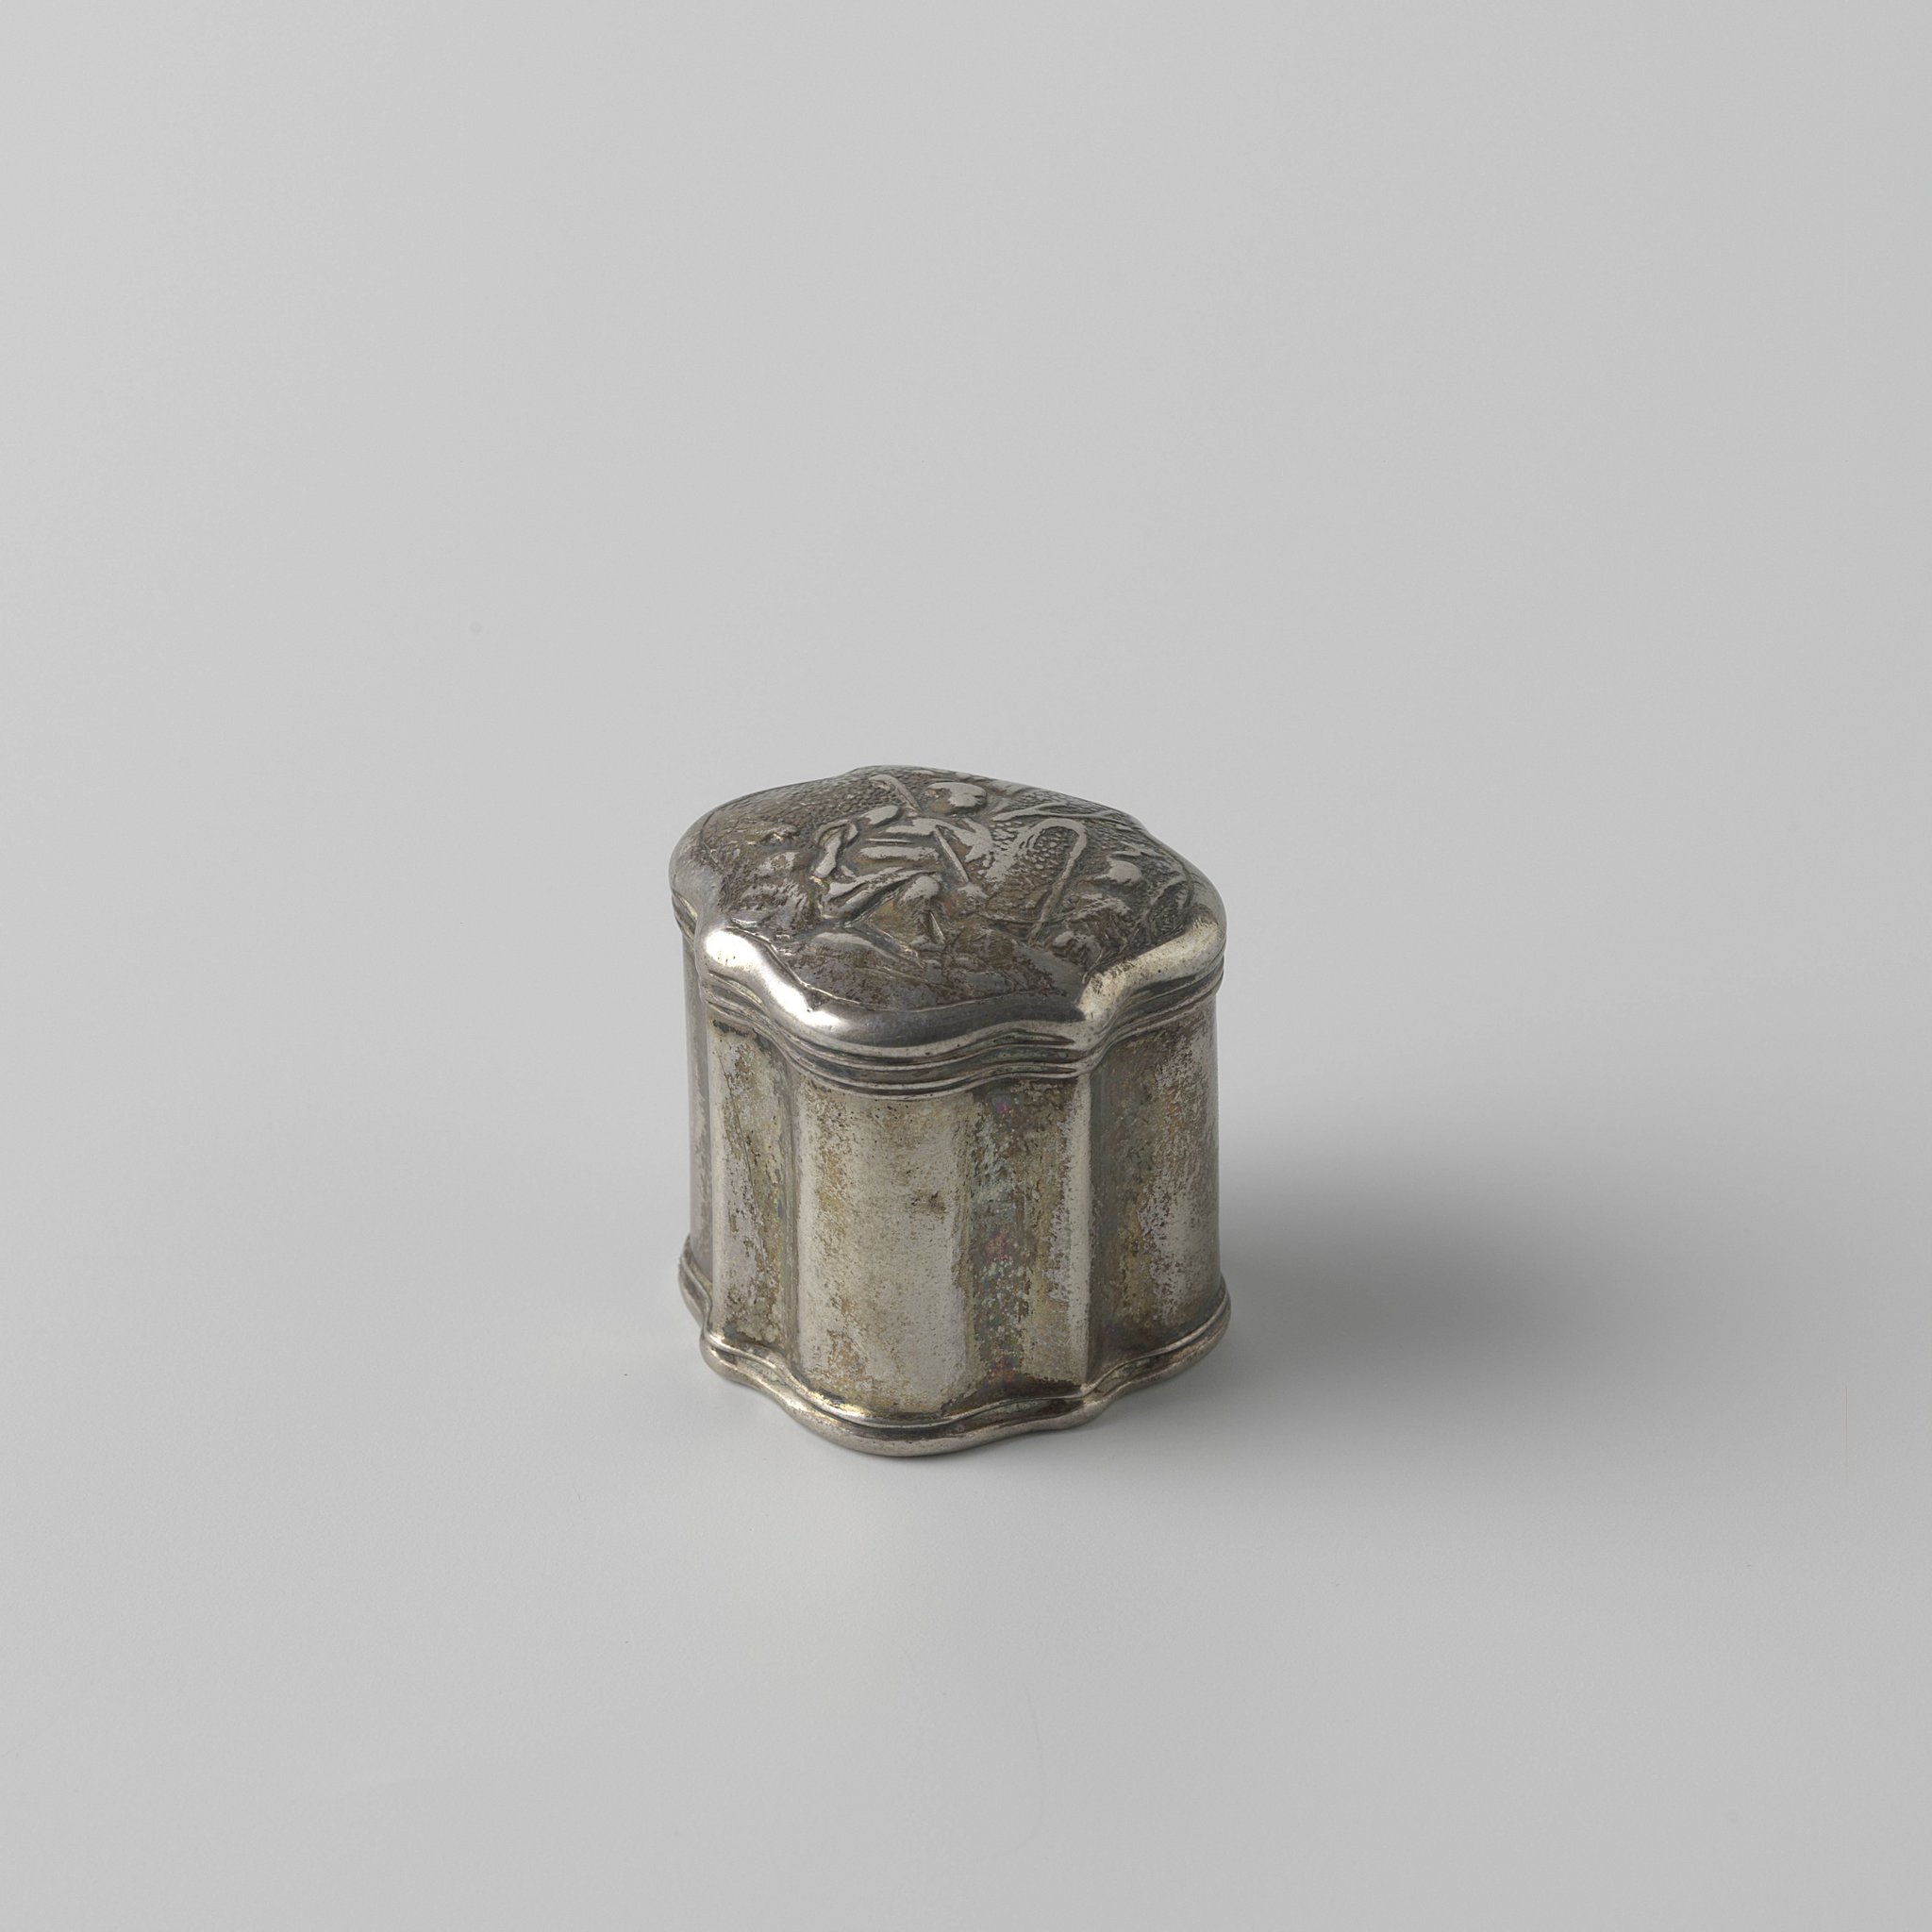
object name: box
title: Loddereindoos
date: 1759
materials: silver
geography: franeker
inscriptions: mark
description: Loddereindoos van zilver, glad en in- en uitzwenkend van omtrek. Op het deksel in reliëf een herderin bij een fontein.